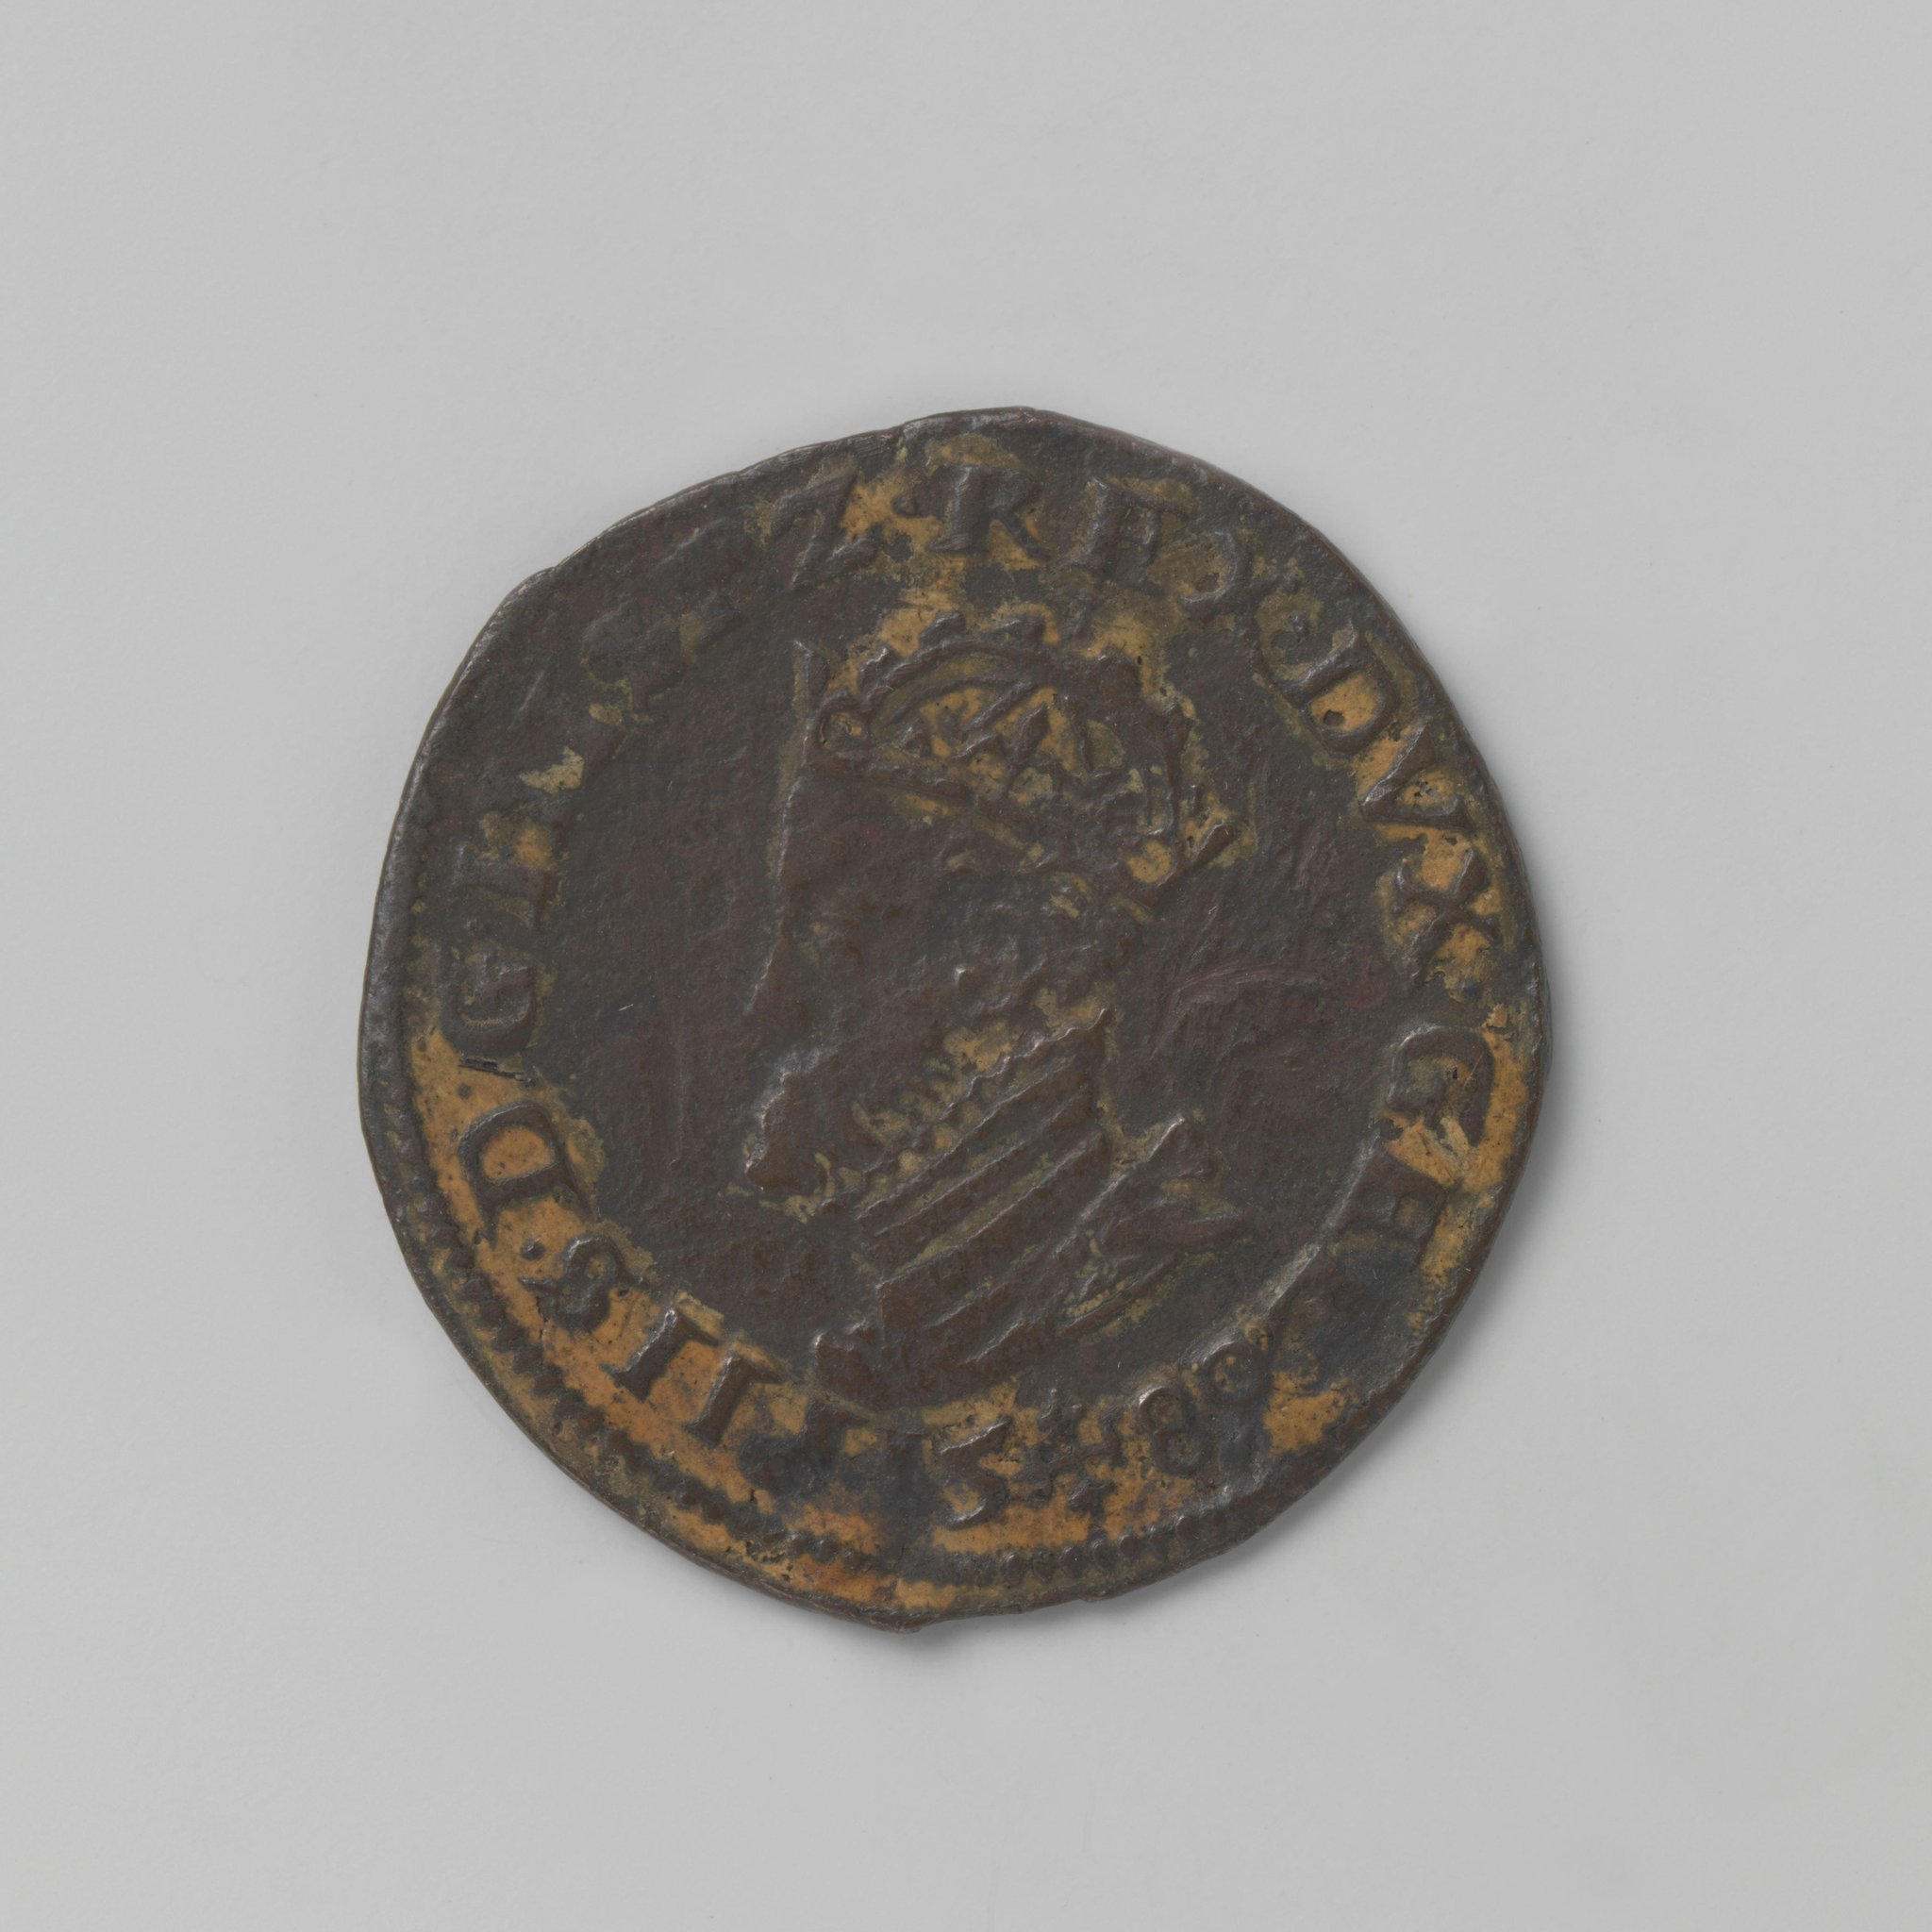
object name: coin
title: Gelderland, Philips II, oord, 1589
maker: philip ii of spain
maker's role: koning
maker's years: 1527-1598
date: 1589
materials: copper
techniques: striking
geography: gelderland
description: Koperen munt. Voorzijde: gekroond bourgondisch wapenschild. Keerzijde: portret van Philips II naar links. Jaartal in omschrift.